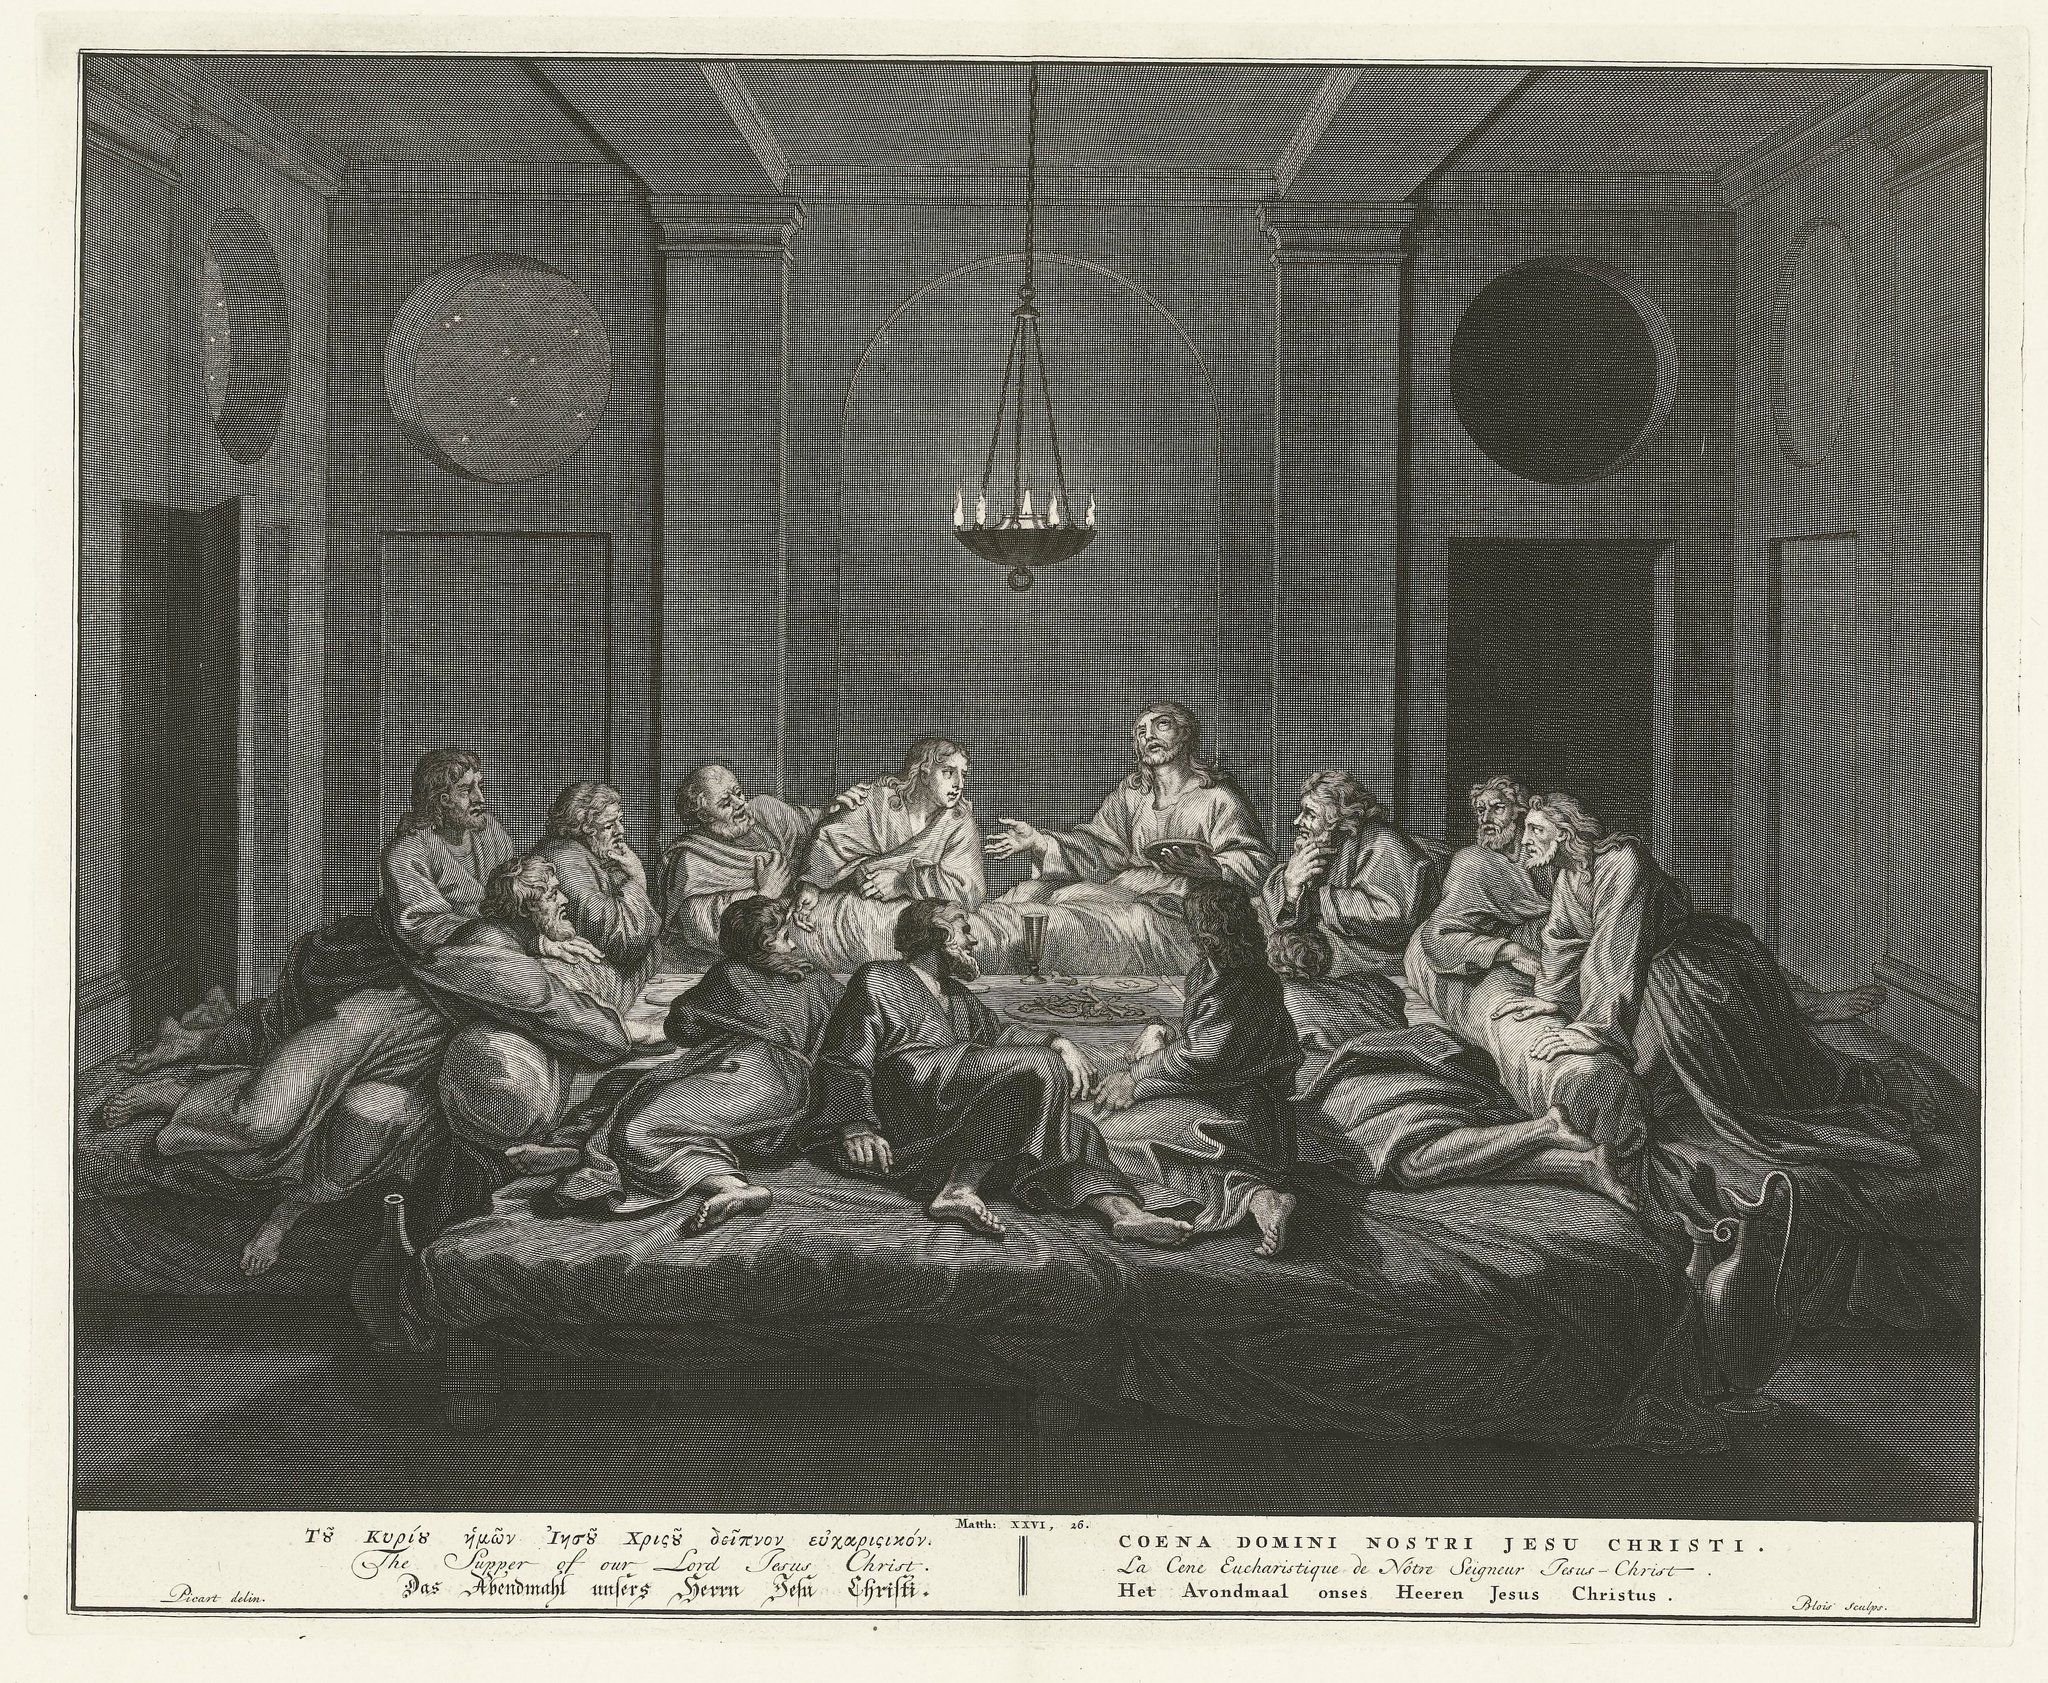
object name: print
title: Het avondmaal onses Heeren Jesus Christus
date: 1679-1717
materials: paper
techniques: engraving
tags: the episode of the last supper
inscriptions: inscription: ‘Utrechts Fundatie huijs’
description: Prent voor: Hoet, Gerard, Taferelen der voornaamste geschiedenissen van het Oude en Nieuwe Testament, en andere boeken, bij de Heilige Schrift gevoegt, door Hoet, Houbraken, en Picart getekent en van de beste meesters in koper gesneden en met beschrijvingen uitgebreid, 3 delen, 's-Gravenhage, Pieter de Hondt, 1728